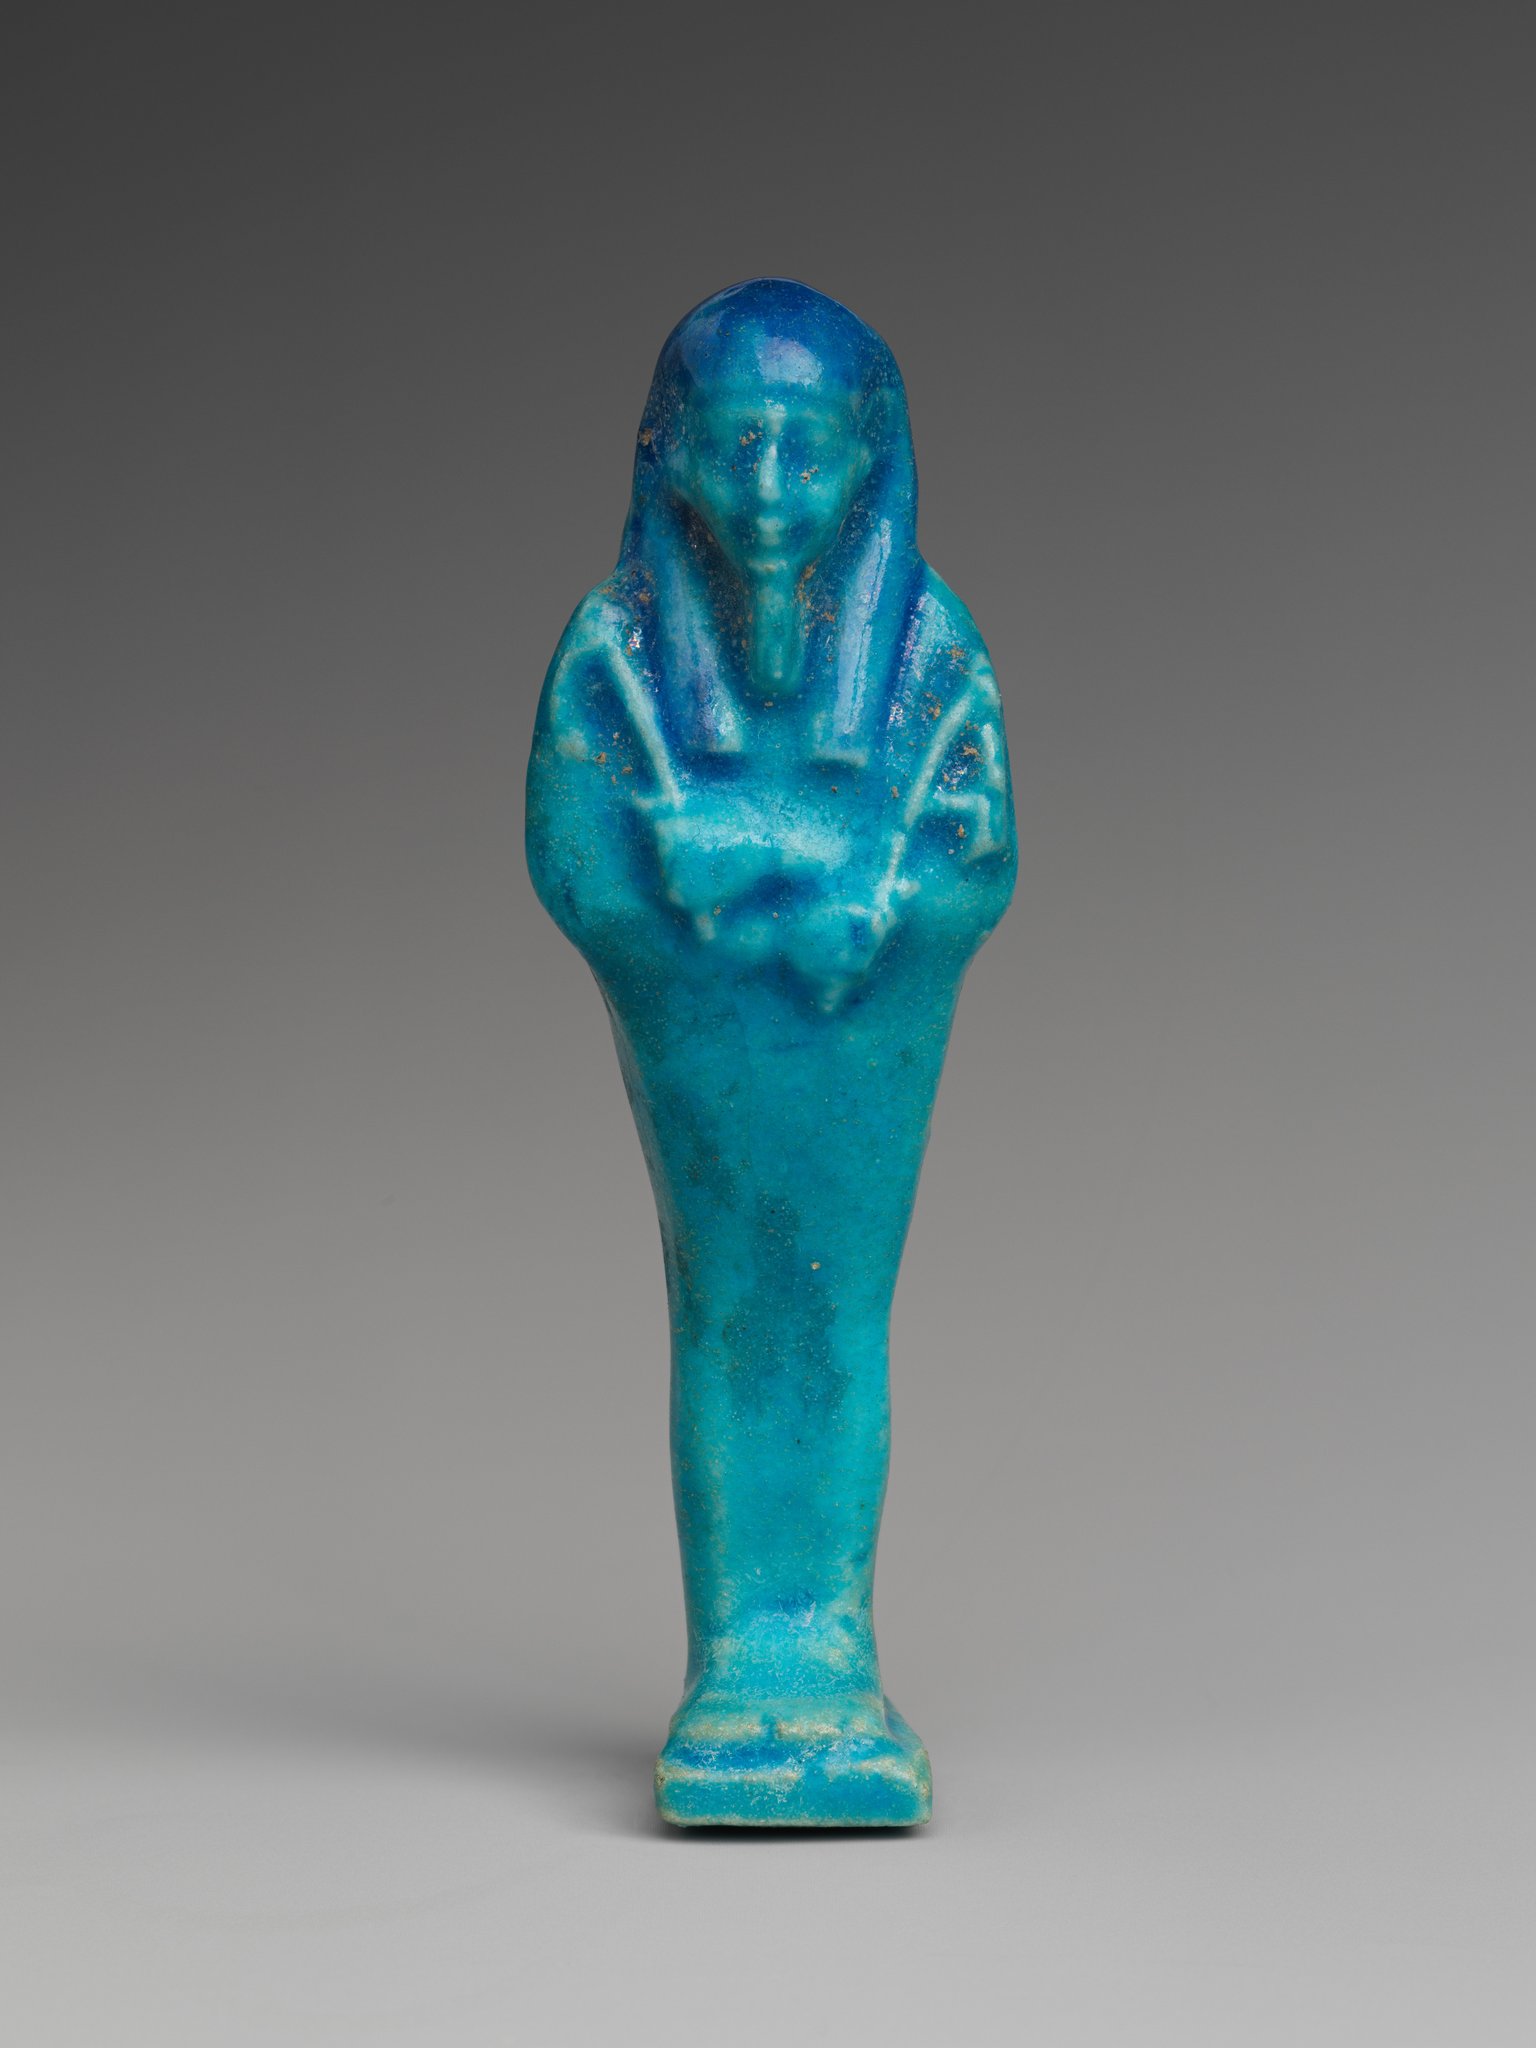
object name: shabti, petosiris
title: Shabti of Petosiris, son of Djedhor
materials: faience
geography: egypt